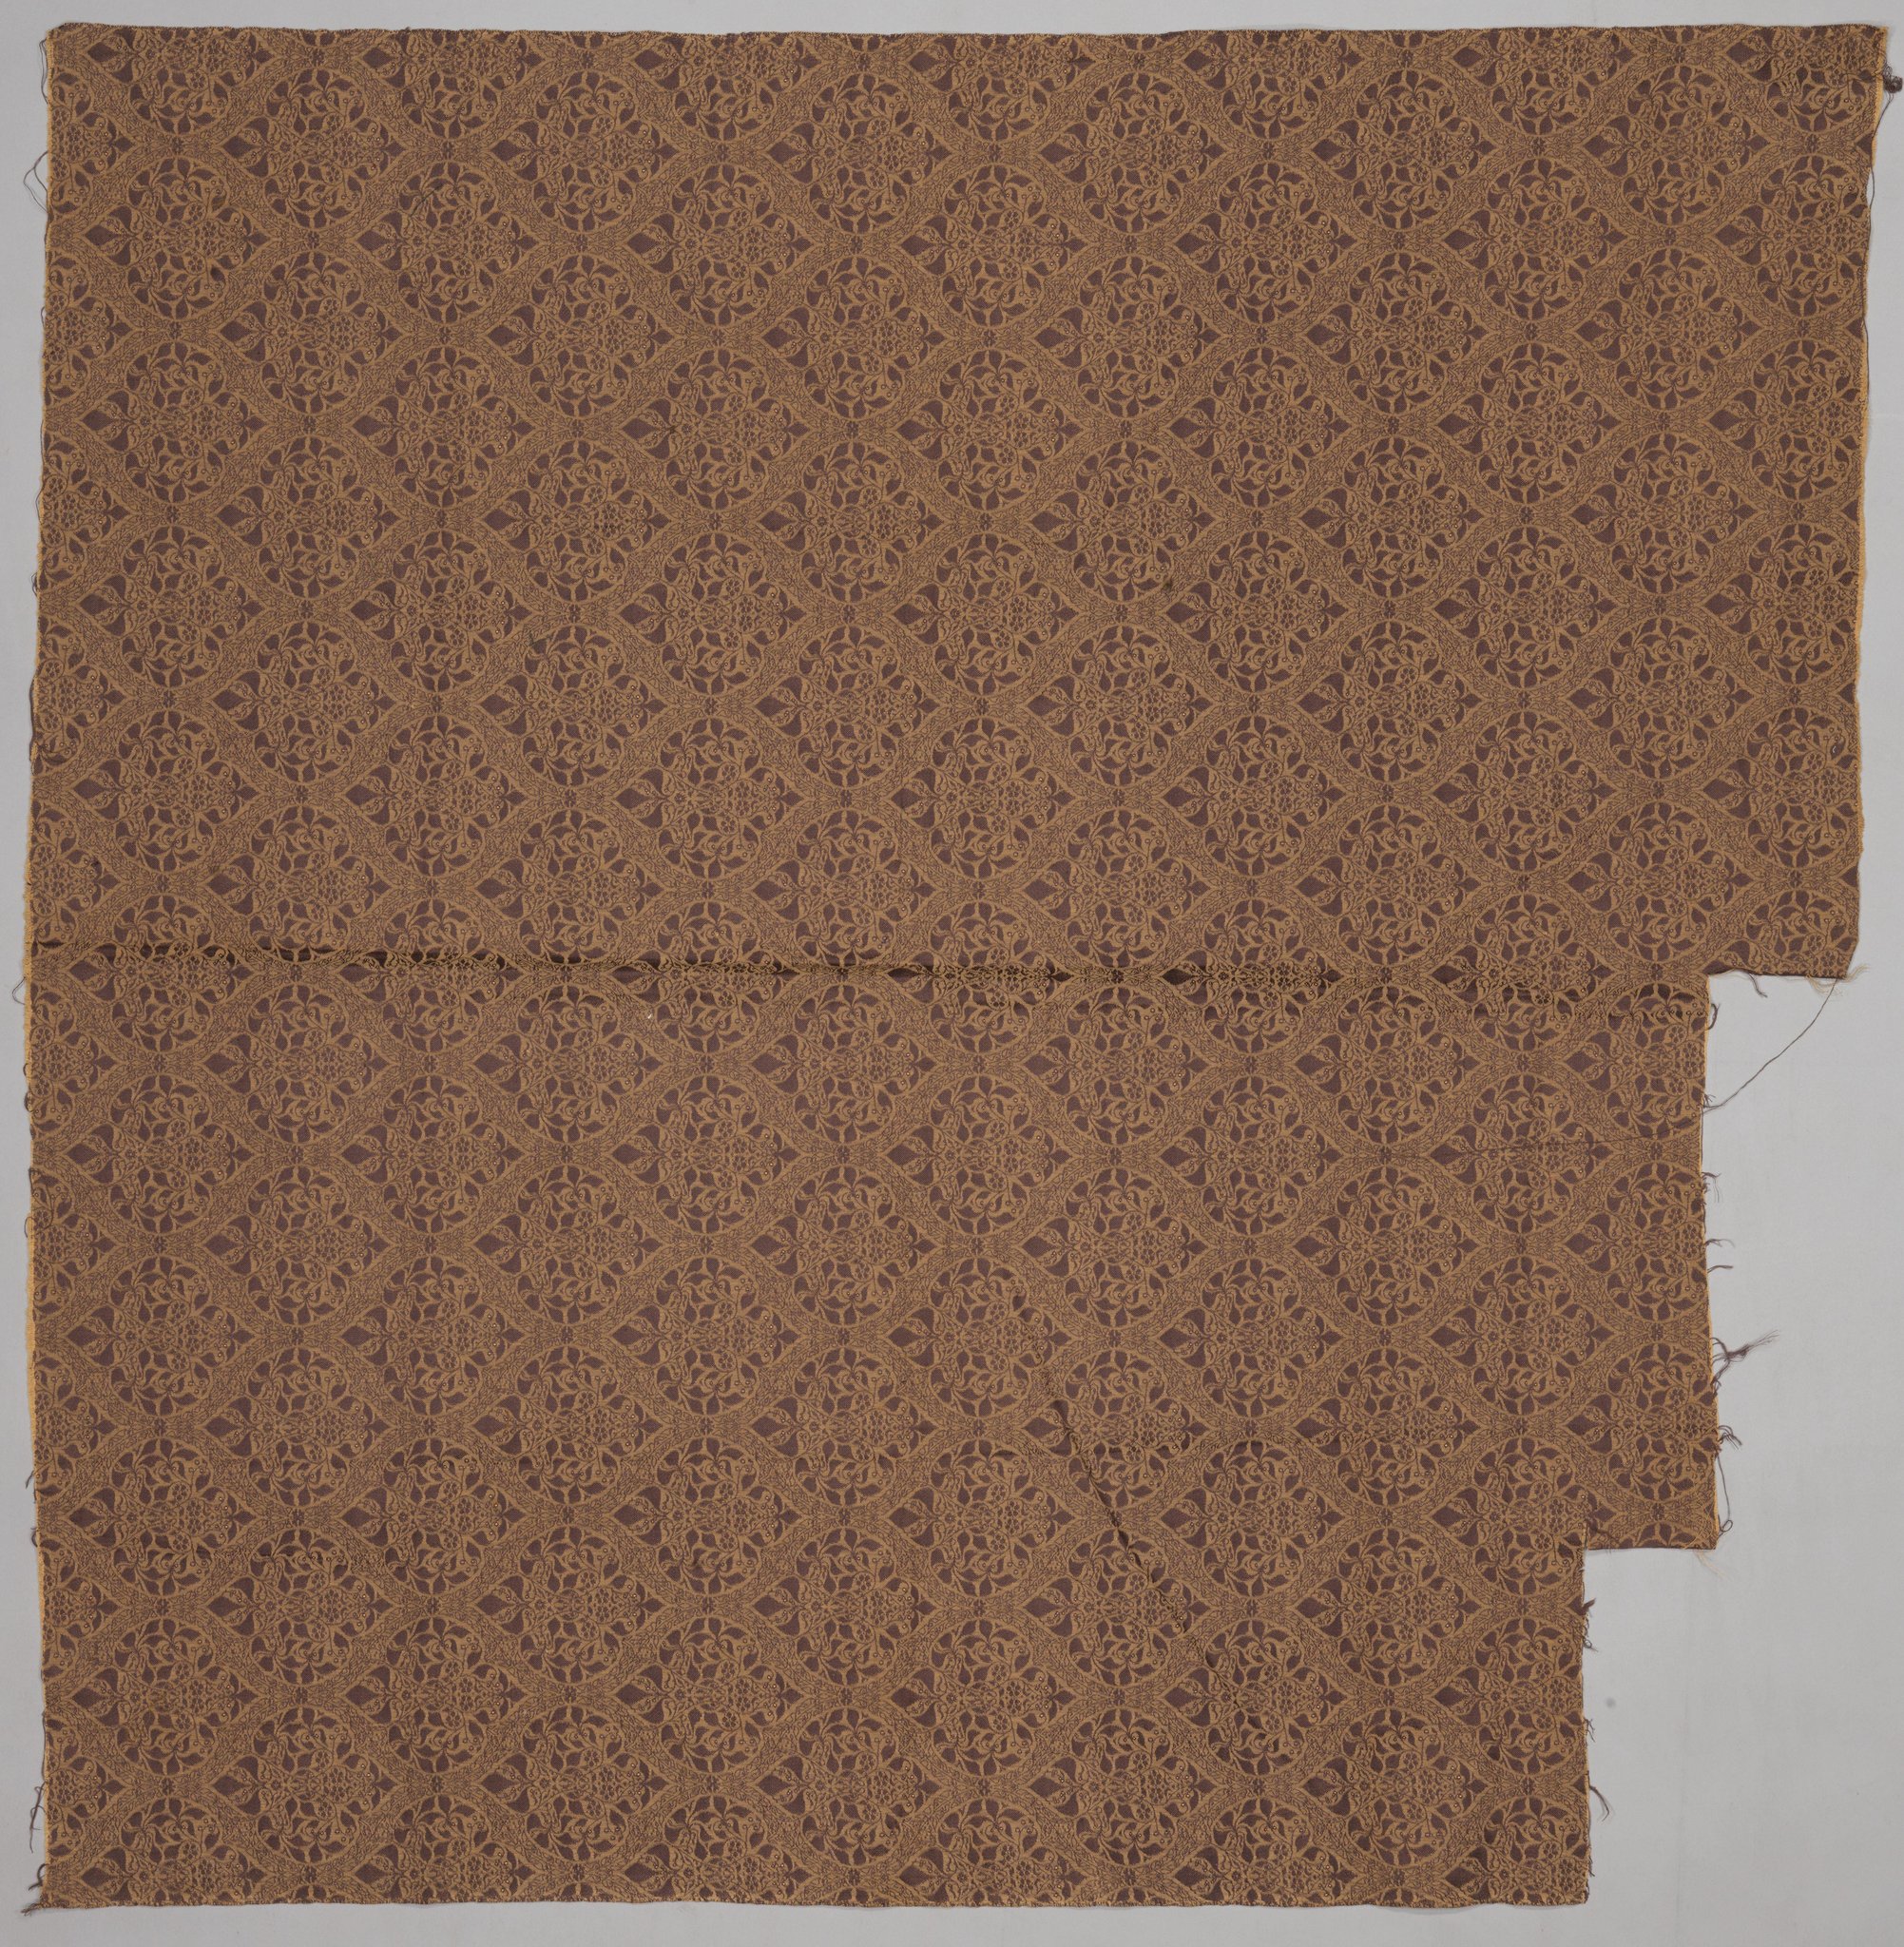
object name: upholstery fabric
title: Bespanningsstof, jacquardweefsel met patroon van spitsovalen met ranken, paarse inslag op bleekgele ketting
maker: theo nieuwenhuis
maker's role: designer, draughtsman, print maker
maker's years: 1866-1951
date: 1920-1930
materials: wool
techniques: jacquard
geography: helmond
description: Bespanningsstof, jacquardweefsel met patroon van spitsovalen met ranken, paarse inslag op bleekgele ketting.